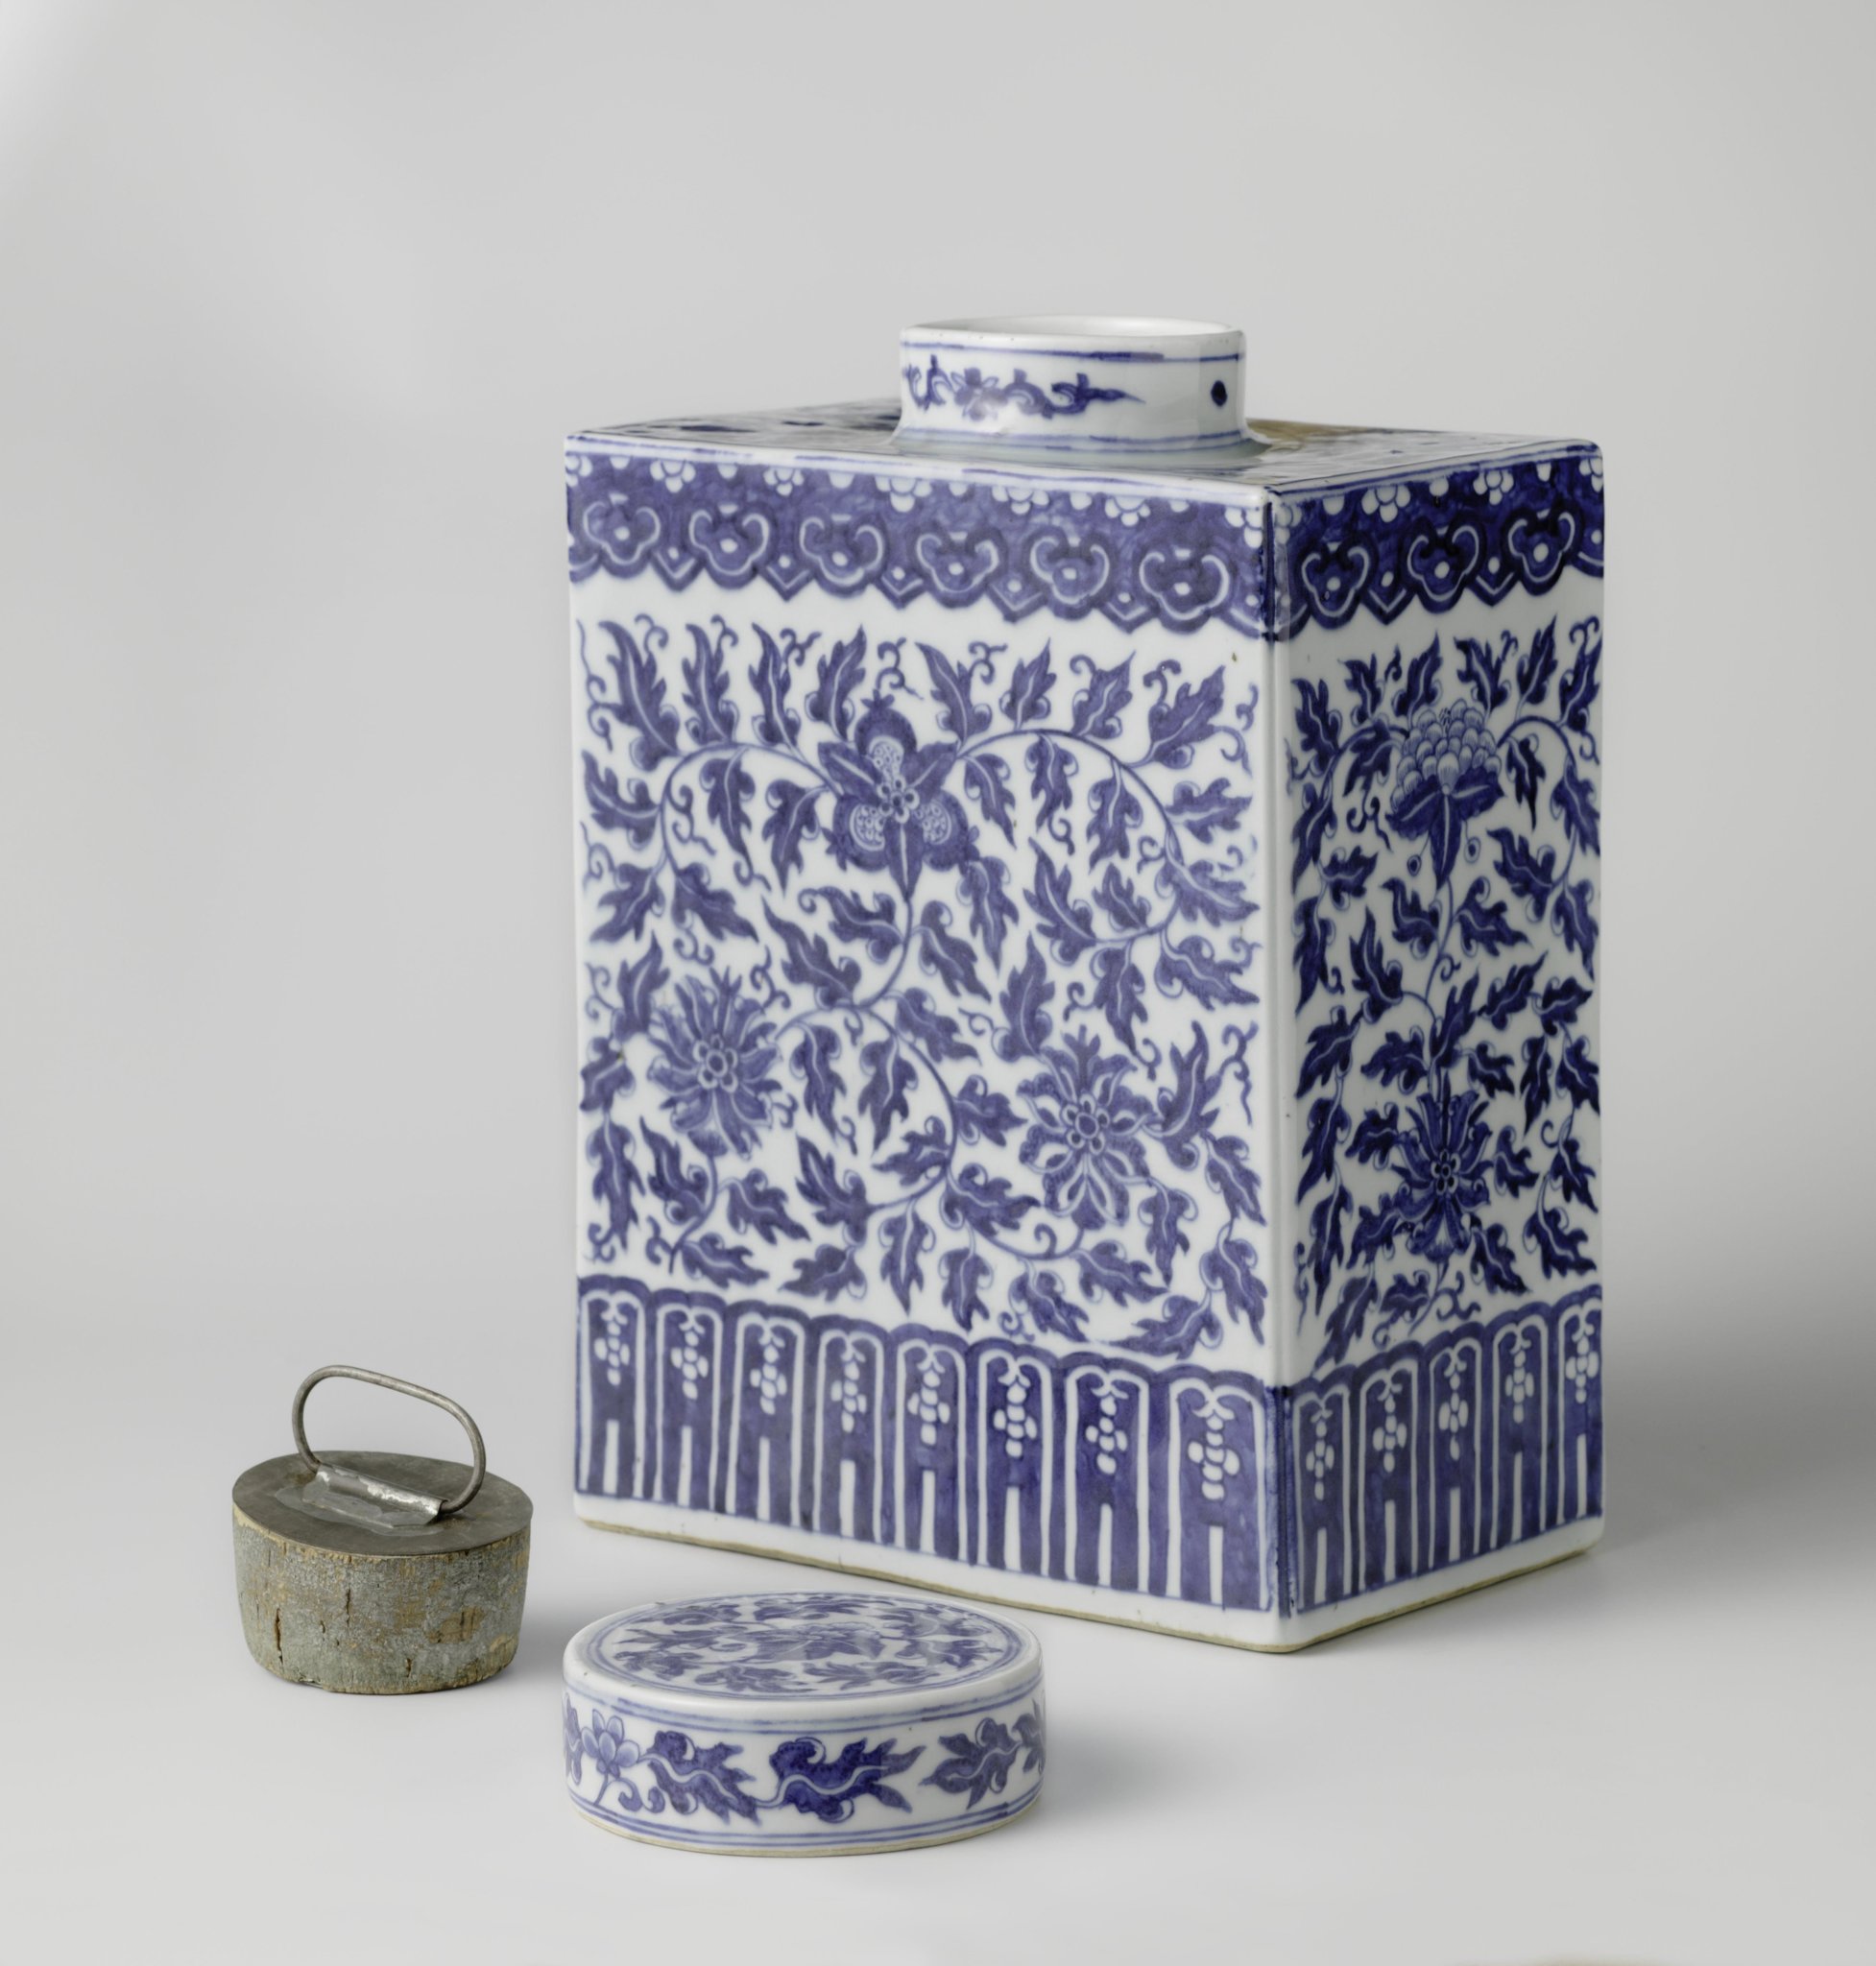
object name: lid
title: Rectangular tea caddy with flower scrolls and bats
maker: Anonymous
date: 1875-1899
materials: cobalt, glaze, paint, porcelain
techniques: firing, turning, vitrification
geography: china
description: Deksel van rechthoekige theebus van porselein, beschilderd in onderglazuur blauw. Gedecoreerd met bloemranken. Blauw-wit.